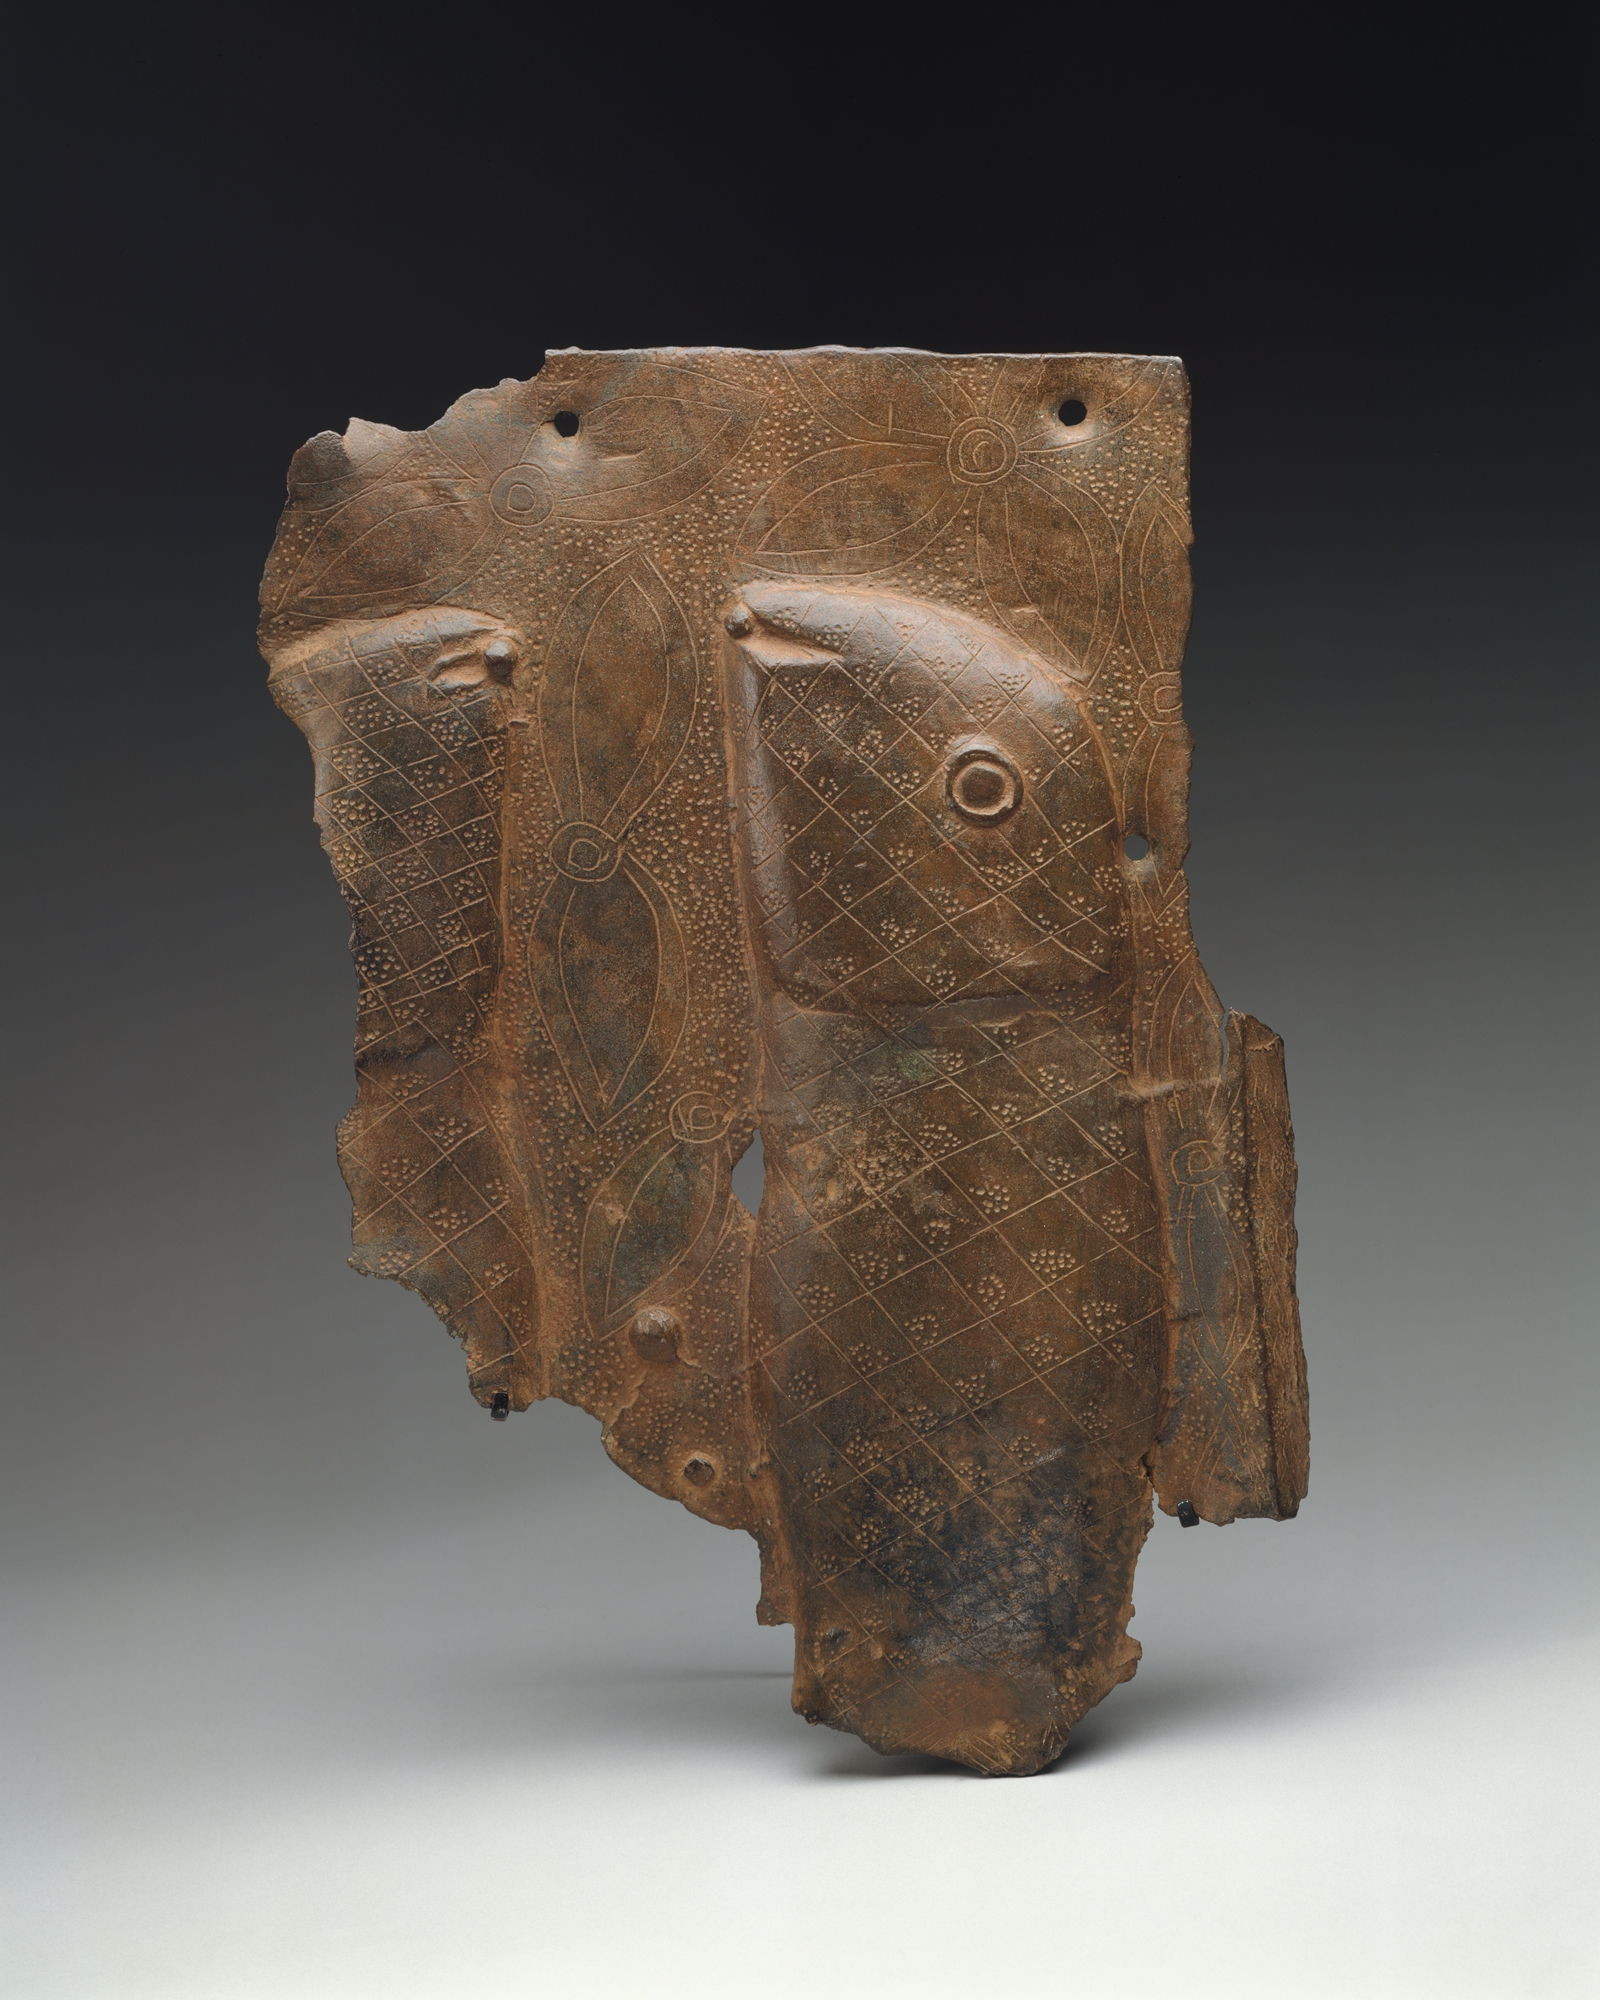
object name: plaque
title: Plaque Fragment with Mudfish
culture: edo period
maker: ìgùn ẹ́rọ̀nwwọ̀n (brass-casting guild) artists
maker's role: artist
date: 1540-1570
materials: brass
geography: nigeria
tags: fish